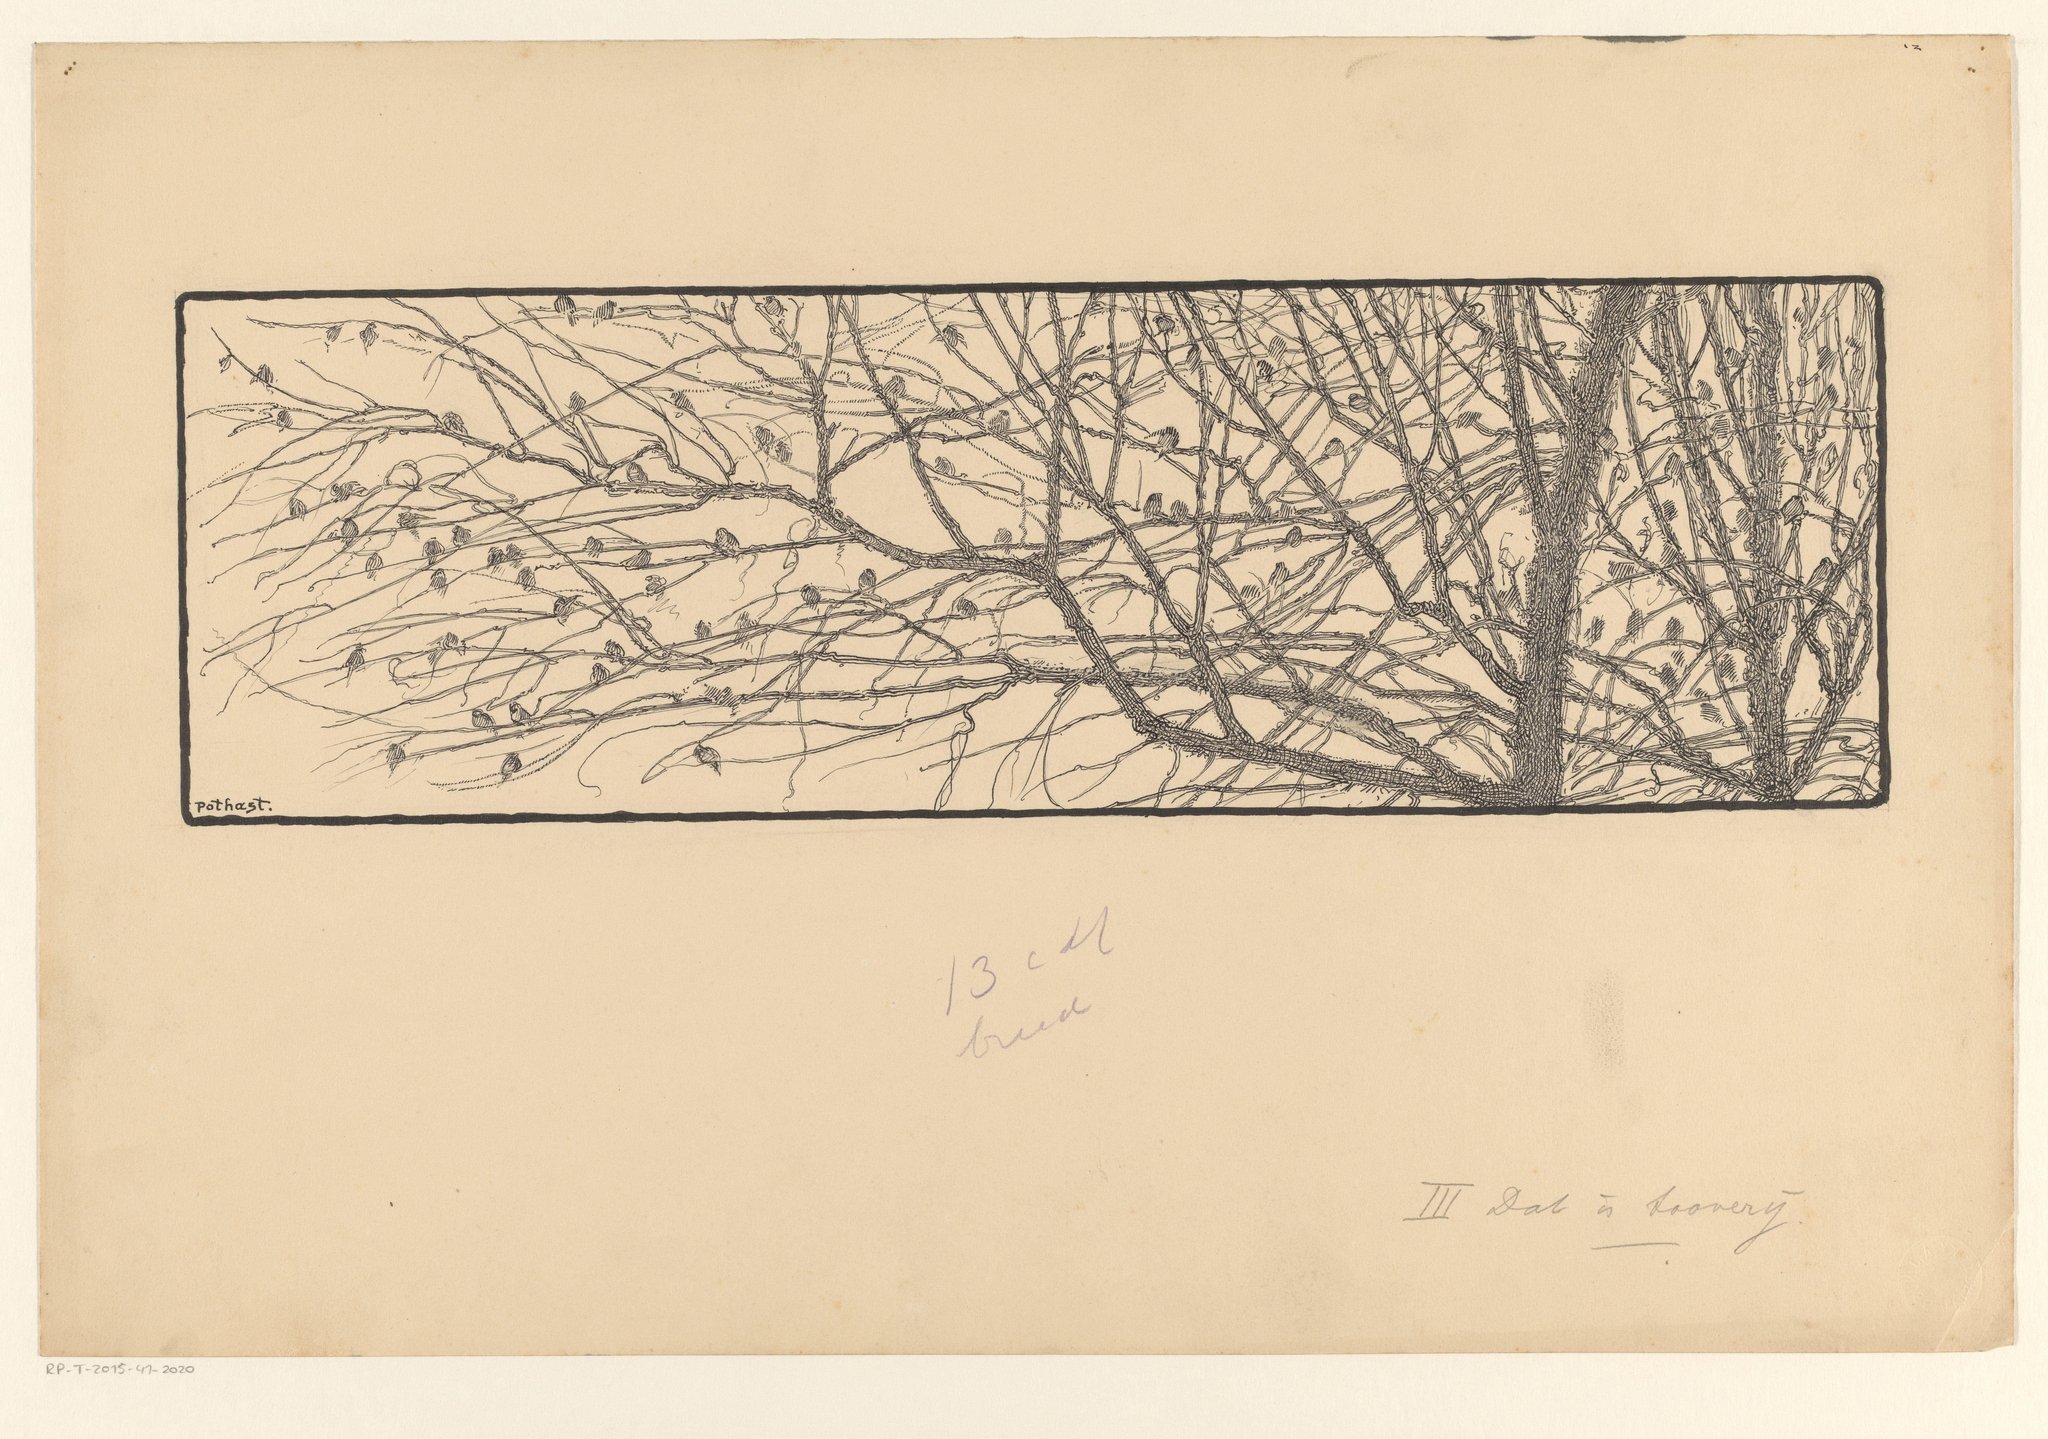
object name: drawing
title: Boomtakken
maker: willem pothast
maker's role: draughtsman, print maker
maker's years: 1877-1916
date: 1887-1916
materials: ink, paper, pencil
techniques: pen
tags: trees (+ branch, stick)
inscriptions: signature: ‘pothast.’, collector's mark: Lugt 2228, annotation: ‘III Dat is tooverij’, retailer's mark: ‘A.J. NUSS/ AMSTERDAM’, :